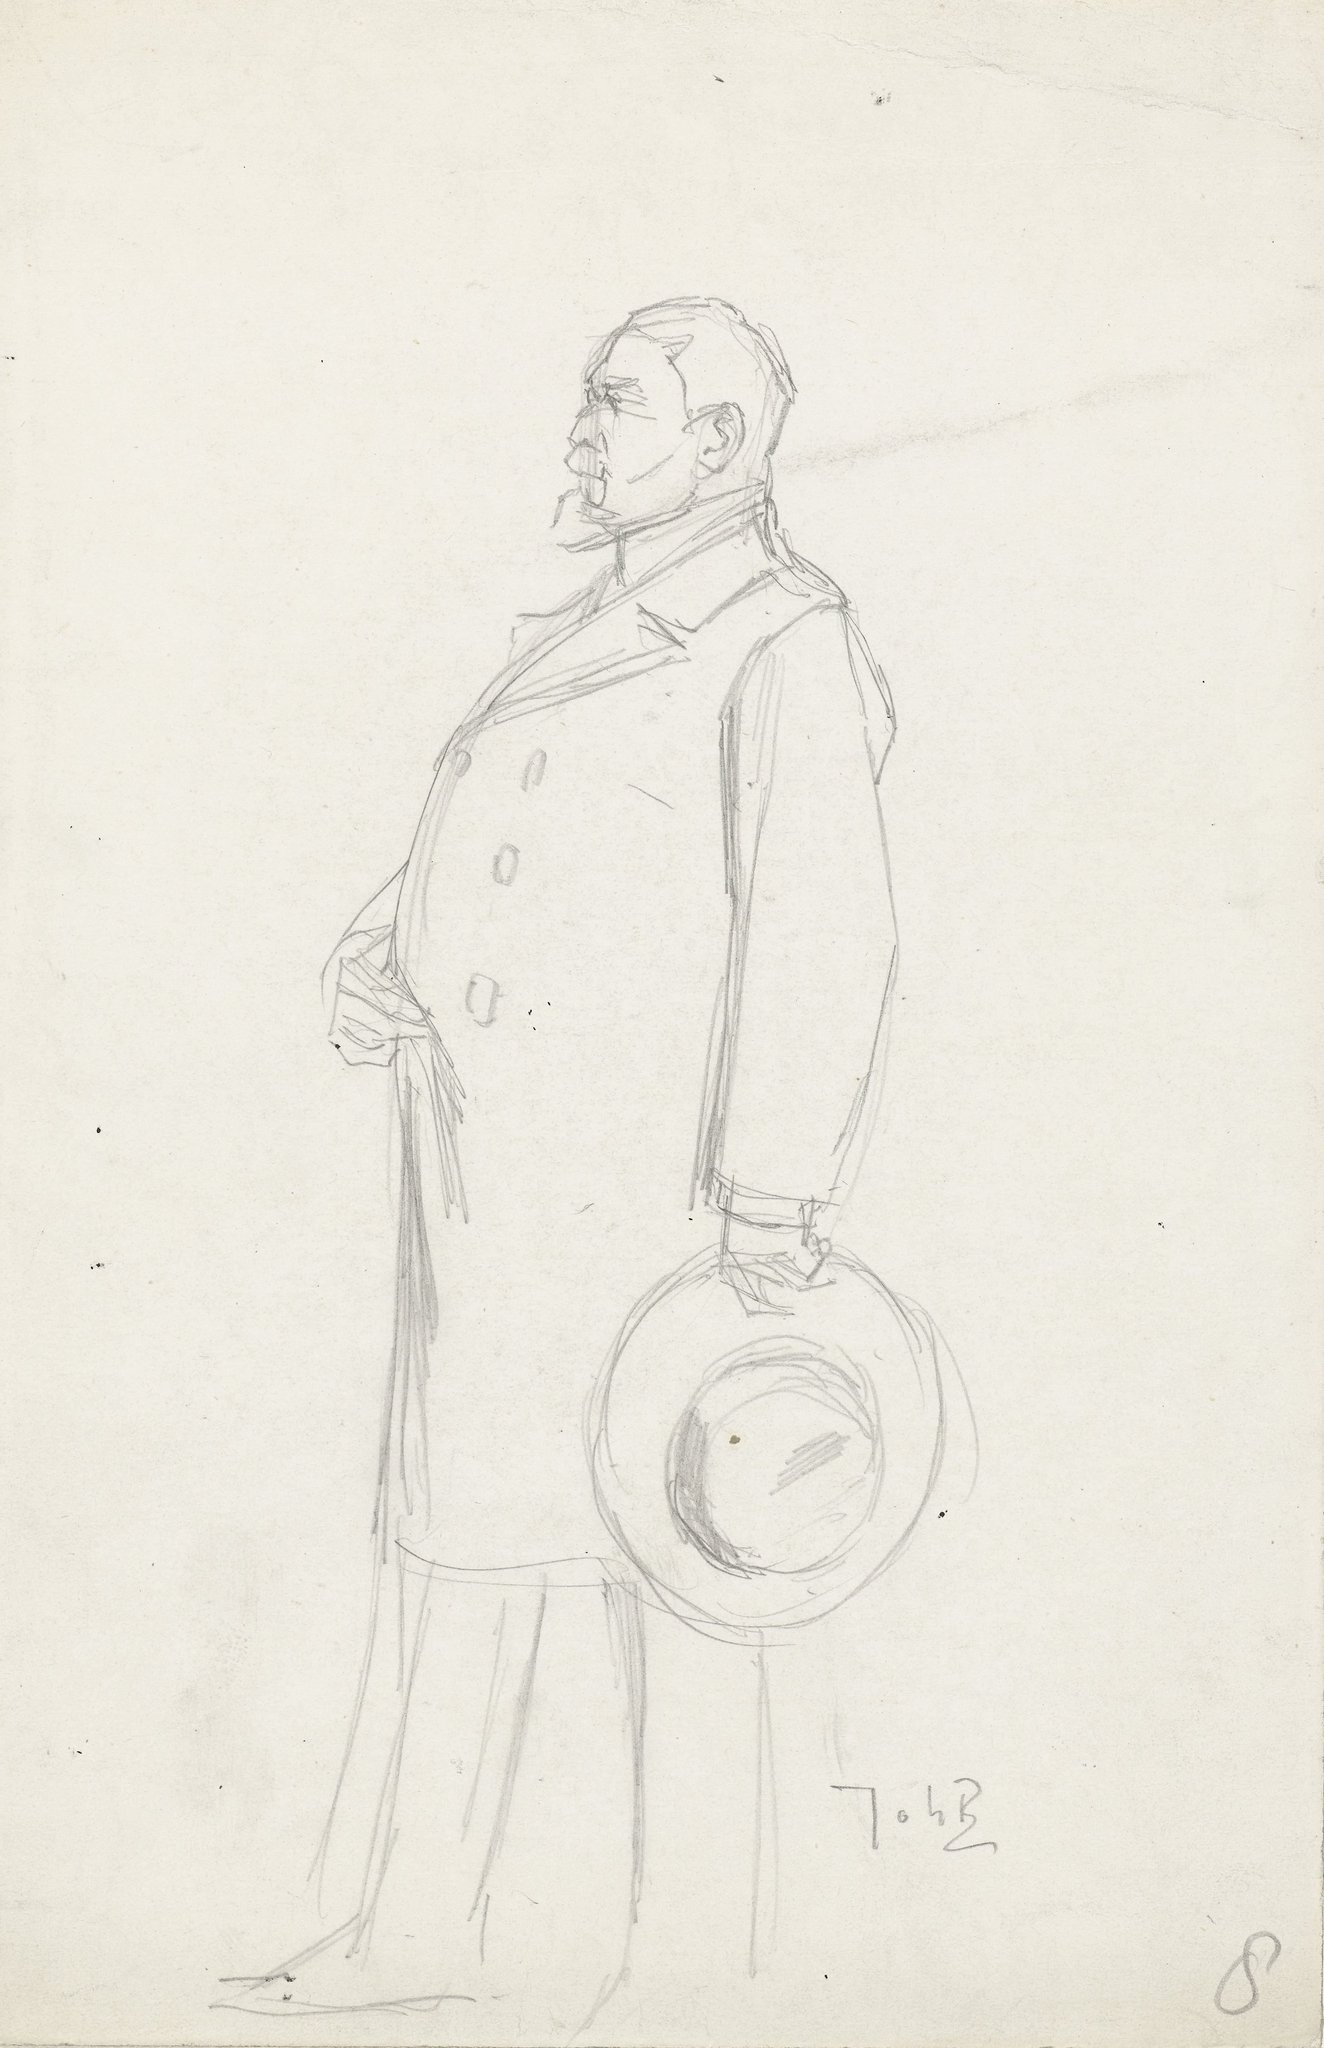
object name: drawing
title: Staande man, van opzij naar links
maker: johan braakensiek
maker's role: draughtsman, print maker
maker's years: 1858-1940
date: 1868-1940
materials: paper, pencil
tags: political meeting, propaganda meeting, historical events and situations, political caricatures and satires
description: Ontwerp voor spotprent op het Sociaaldemocratisch Congres te Amsterdam, 1904. Ontwerp voor een prent.